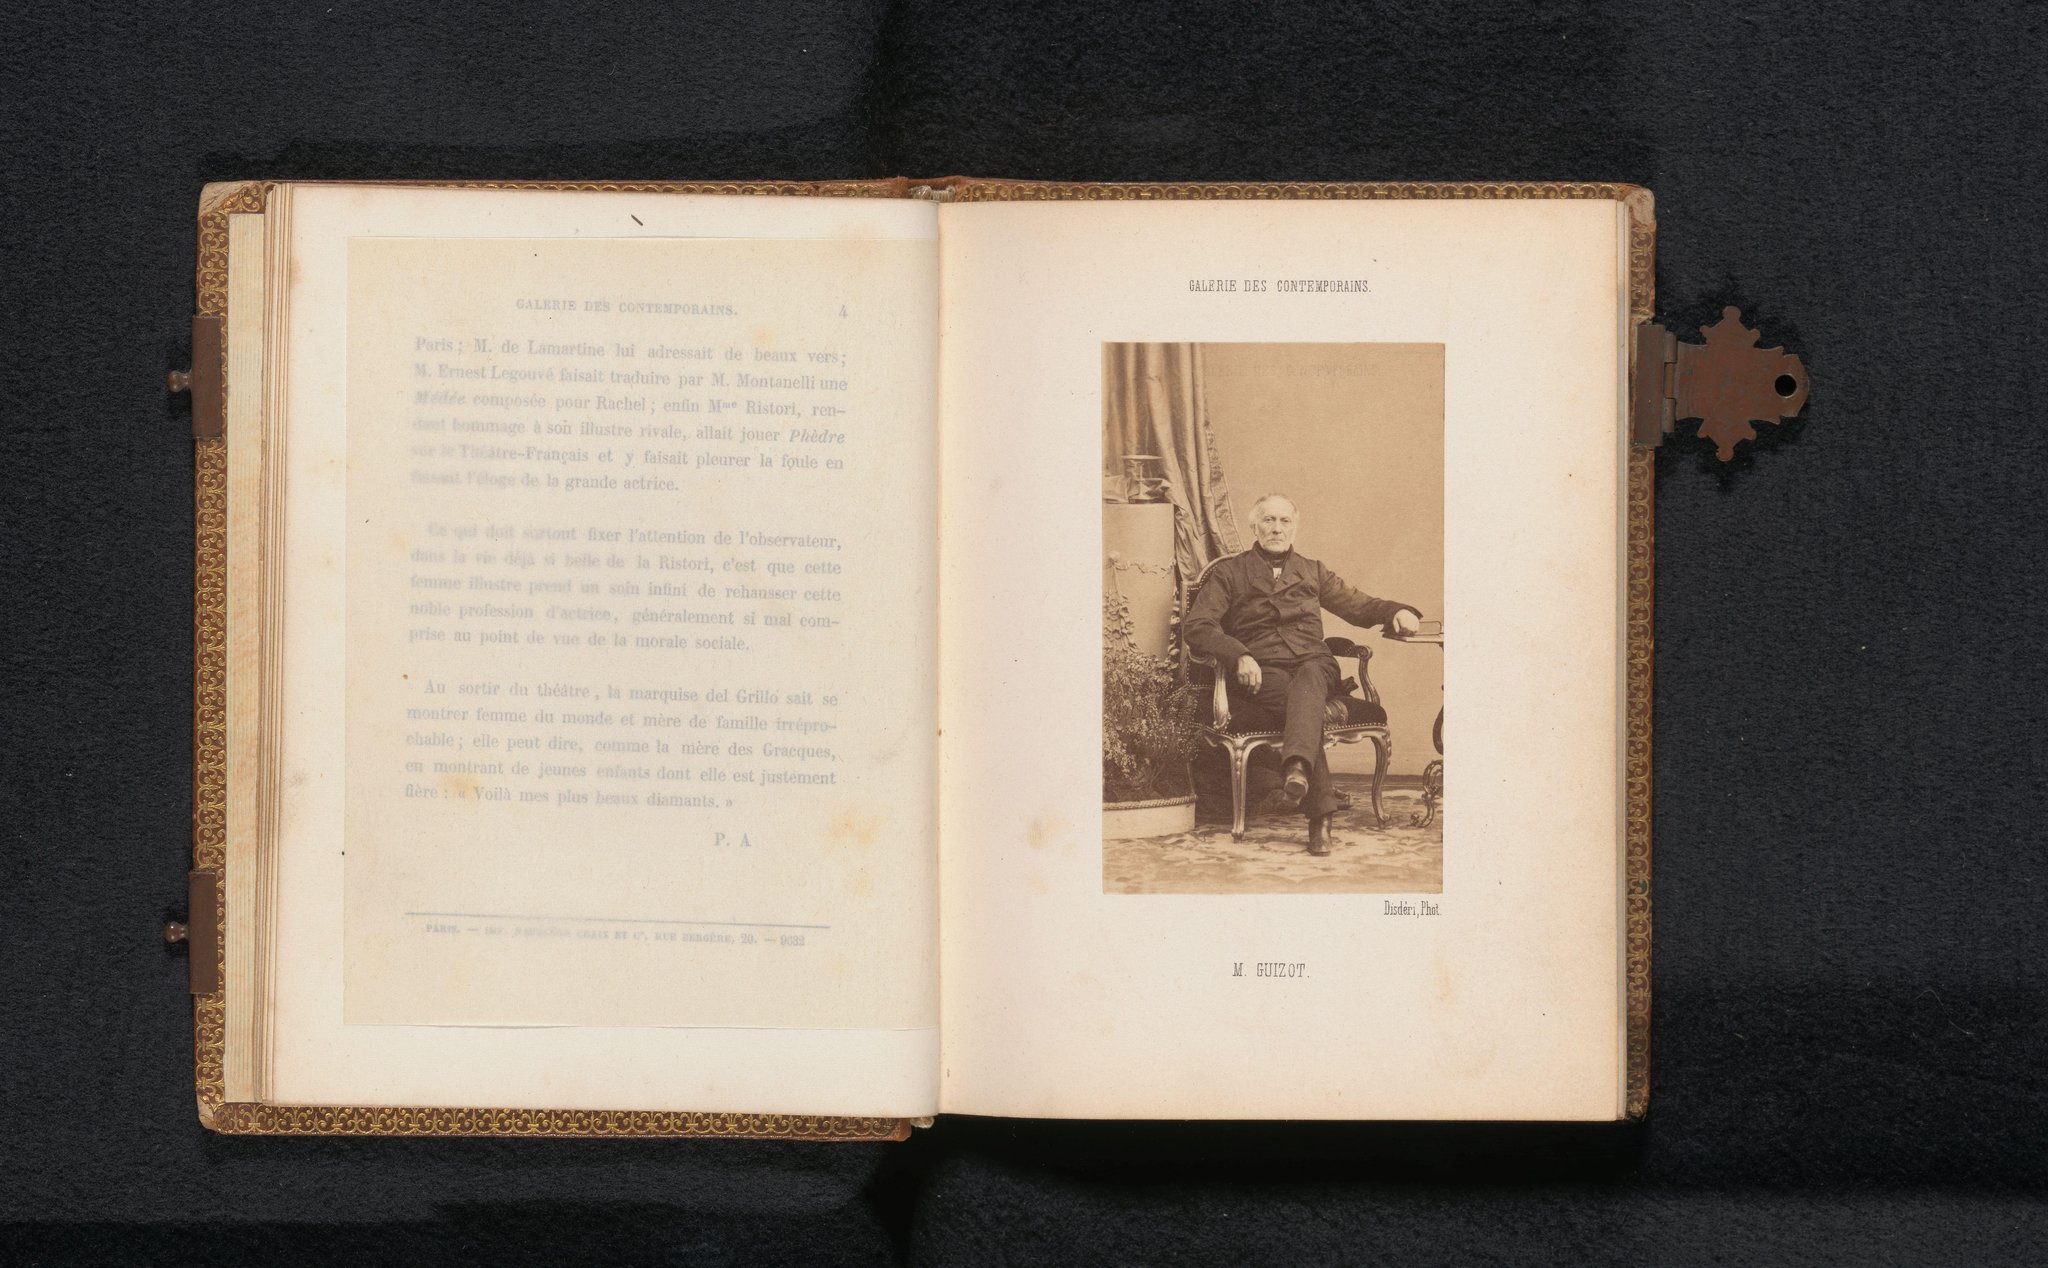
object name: photograph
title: Portret van François Guizot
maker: andré-adolphe-eugène disdéri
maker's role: fotograaf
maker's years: 1819-1889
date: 1857-1862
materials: photographic support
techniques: albumen print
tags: adult man, historical persons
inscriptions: inscription: ‘Galerie des Contemporains’